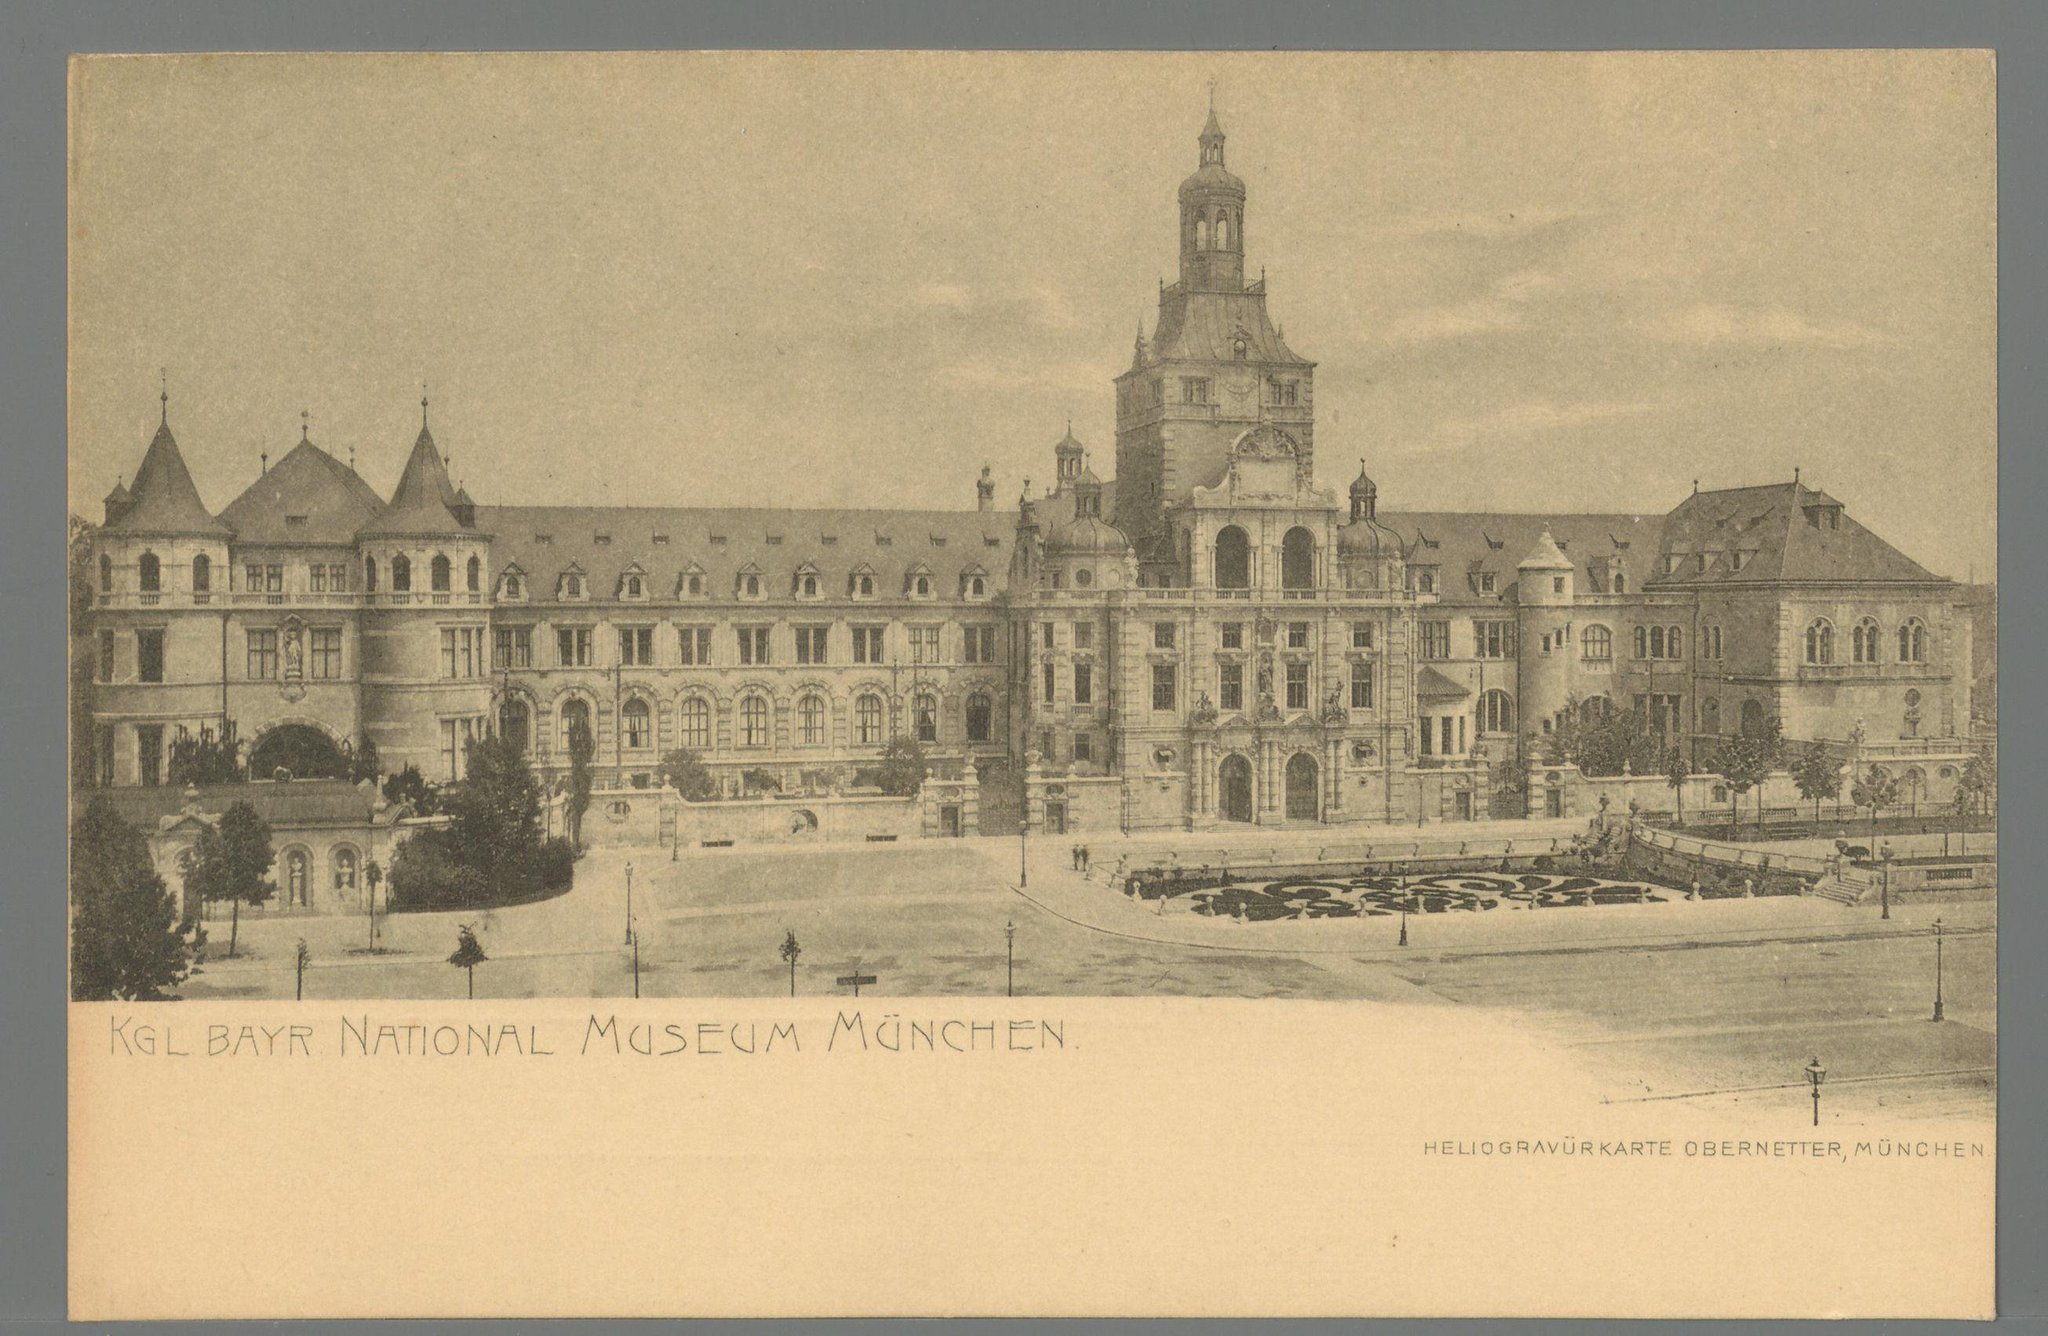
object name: ansichtkaart, prentbriefkaart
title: Kgl Bayr National Museum München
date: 1885-1905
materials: cardboard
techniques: photoaquatint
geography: munich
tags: permanent exhibition, museum